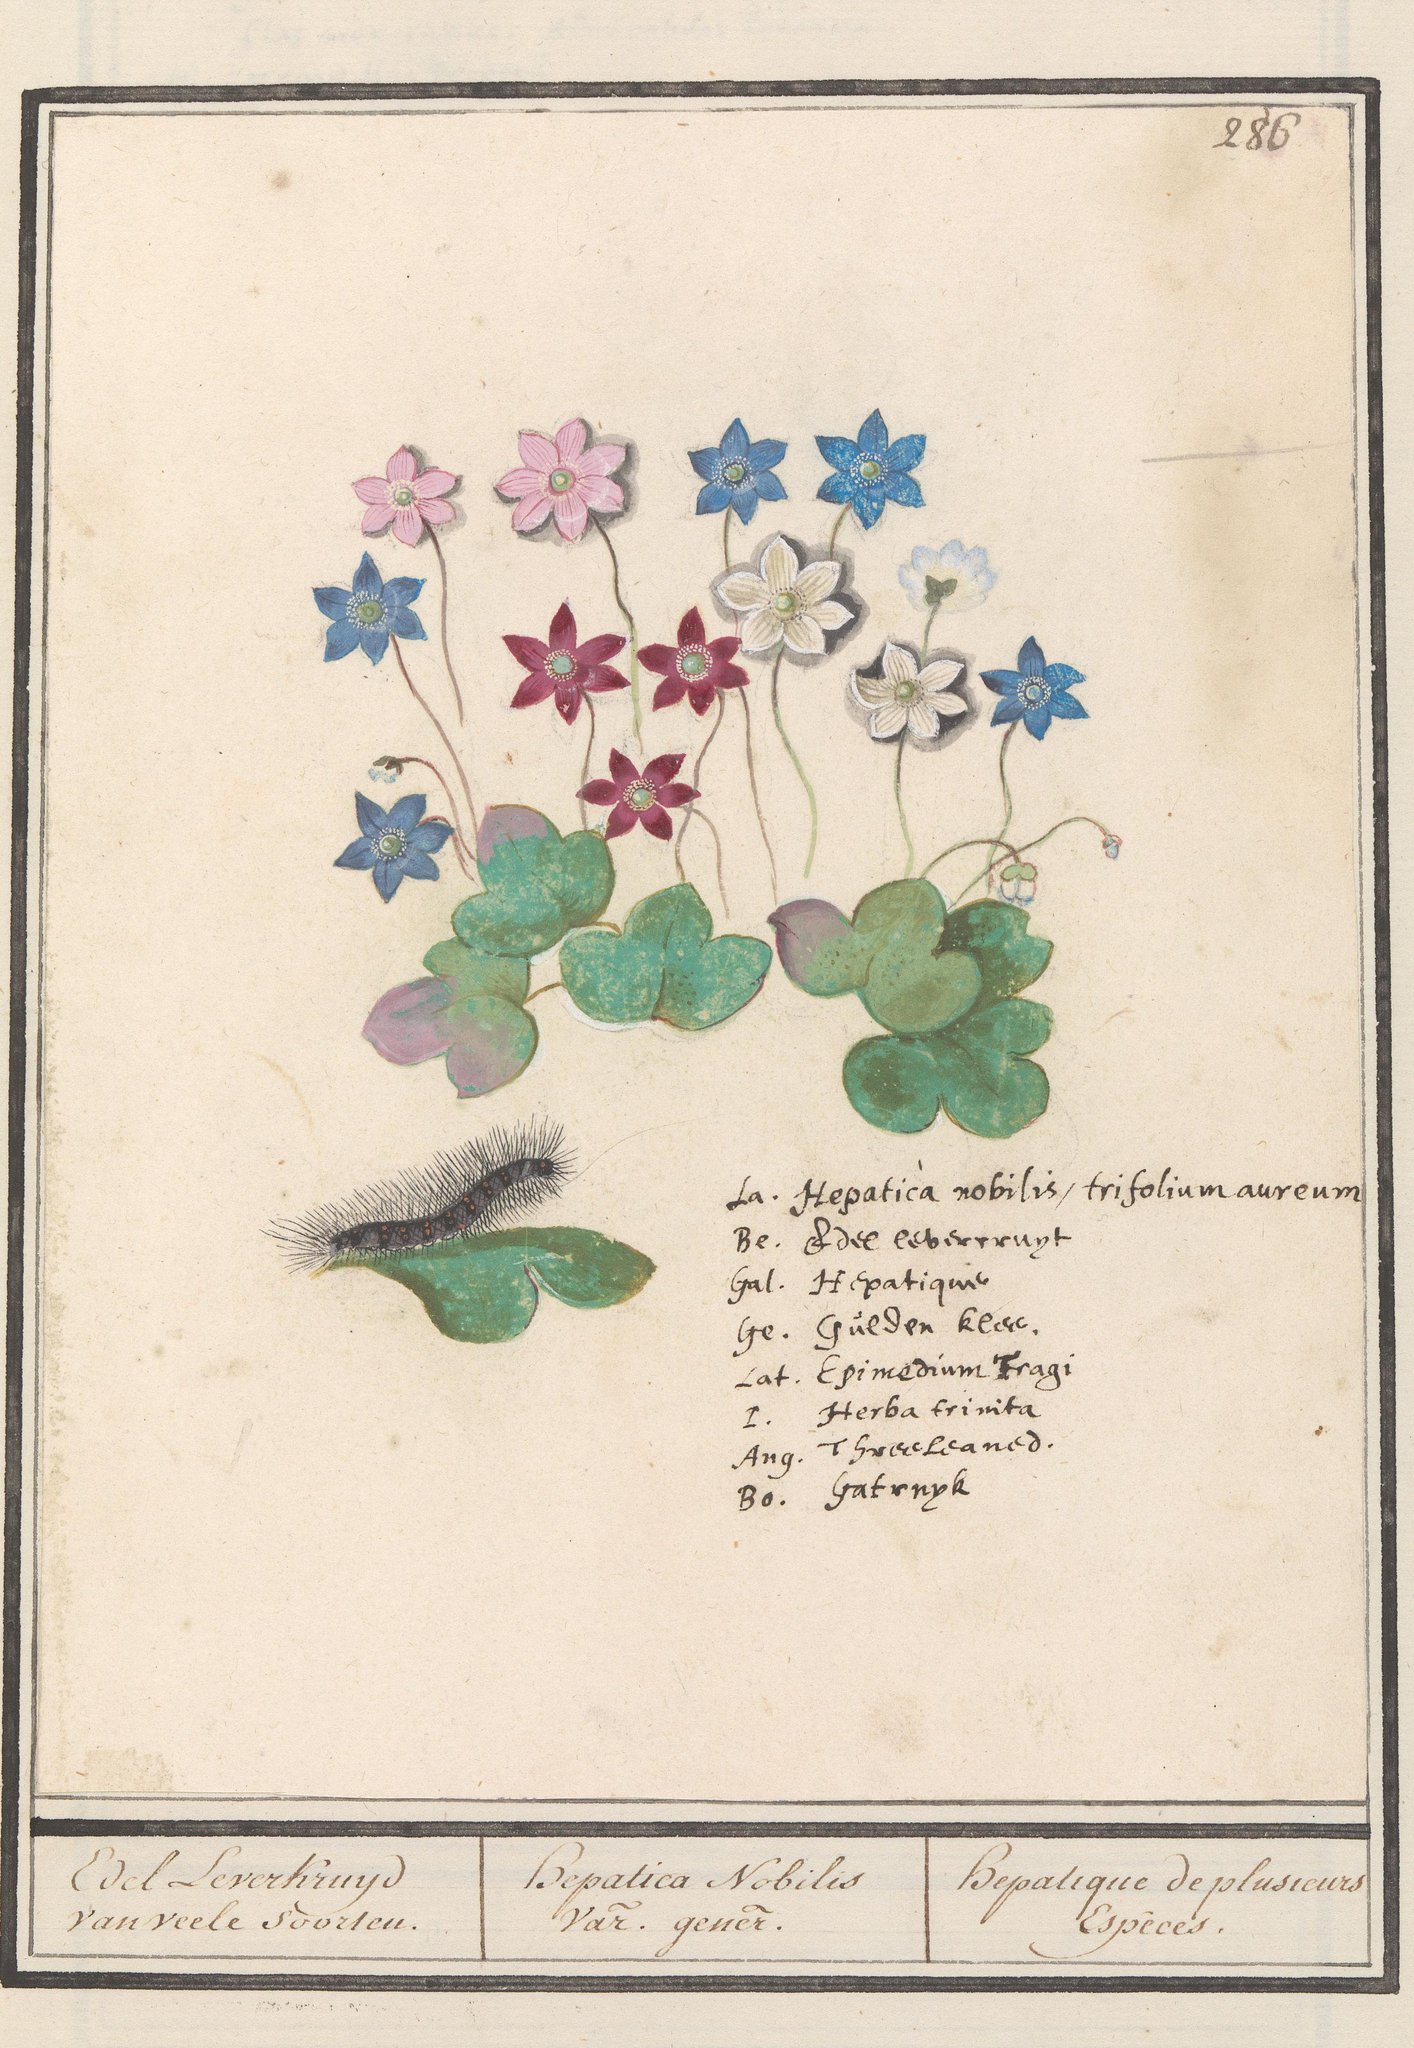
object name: drawing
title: Leverbloempje (Anemone hepatica, oude naam: Hepatica nobilis)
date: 1596-1610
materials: chalk, paint, ink, paper, watercolor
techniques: brush, pen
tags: flowers: anemone hepatica, insects: caterpillar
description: Verschillende sooten leverbloempje. Met een rups op een blad. Genummerd rechtsboven: 286. Rechtsonder de naam in acht talen. Onderdeel van het derde album met tekeningen van bloemen en planten. Tiende van twaalf albums met tekeningen van dieren, vogels en planten bekend rond 1600, gemaakt in opdracht van keizer Rudolf II. Met toelichting in Nederlands, Latijn en Frans.